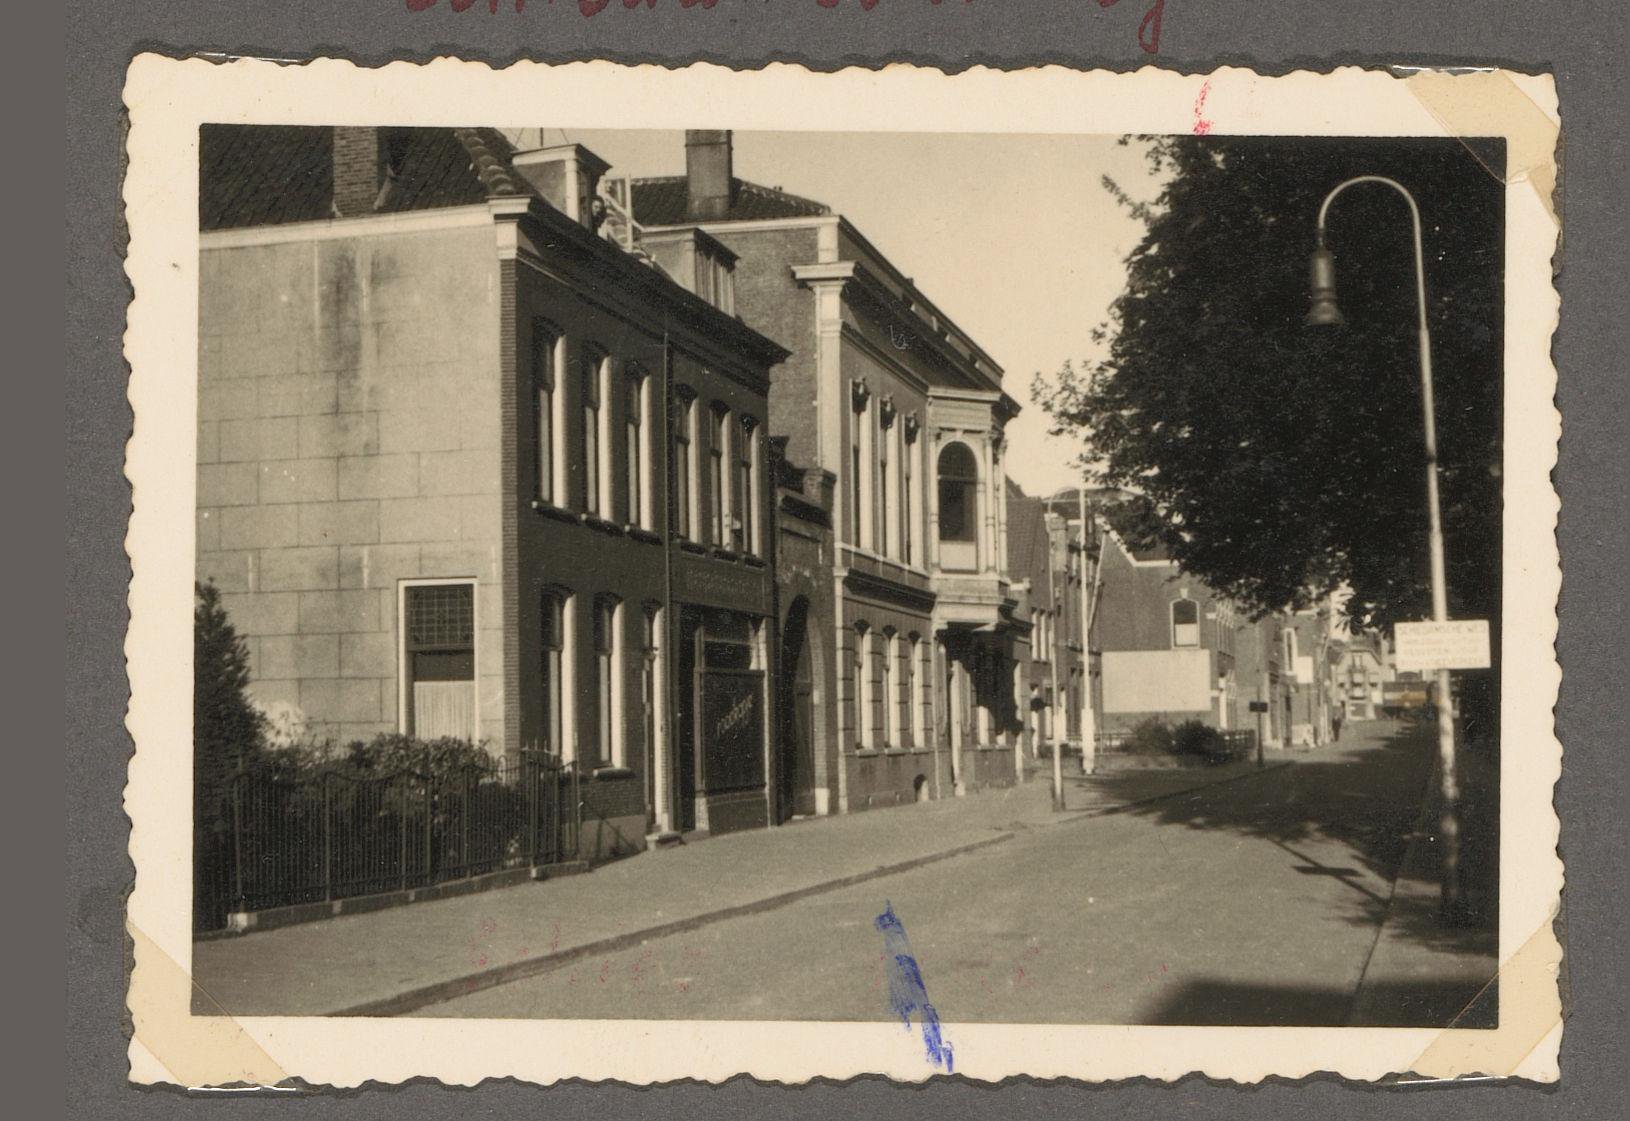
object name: album leaf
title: Gezicht op de Schiedamseweg te Vlaardingen met de Dienststelle van de 9. Minenräumflottille van de Duitse Kriegsmarine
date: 1941-1945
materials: paper, photographic support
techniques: gelatin silver print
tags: street, rotterdam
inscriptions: annotation: ‘Vlaaringen/Rotterdam’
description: Gezicht op de Schiedamseweg te Vlaardingen met in het midden het wit gepleisterde gebouw met erker in gebruik als Dienststelle van de 9. Räumbootsflottille van de Duitse Kriegsmarine. Rechts bomen van de tuin van Zaal Harmonie, waar tijdens een deel van de Tweede Wereldoorlog aarden schuilkelders ten behoeve van het Kriegmarine-personeel lagen.